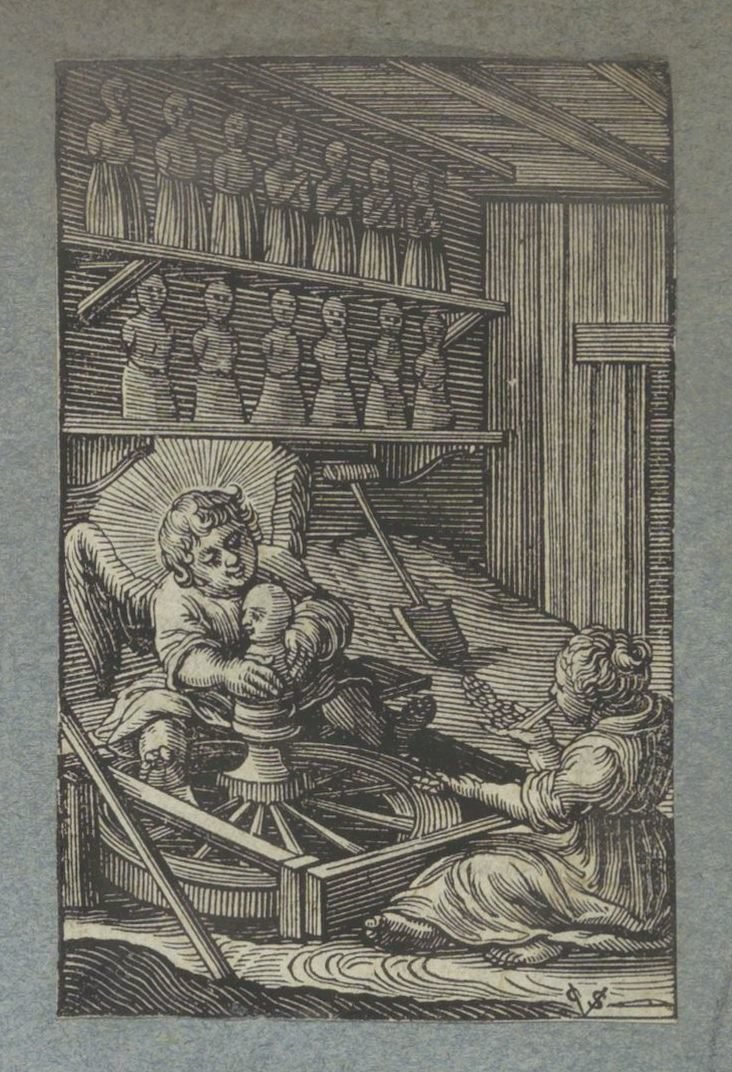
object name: book illustration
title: Pia Desideria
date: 1628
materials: paper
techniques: woodcut, pasting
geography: antwerp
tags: handicrafts ~ clay, sand, chalk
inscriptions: collector's mark: Lugt 2165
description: Een kind kijkt toe hoe een engel een beeldje maakt van klei op een draaitafel. Dit is een verwijzing naar hoe God de mens schiep uit klei. Achter de engel twee planken met meer beeldjes. Het kind blaast droge klei deeltjes als een wolkje stof van haar hand als teken van de vergankelijkheid van de mens. De prent maakt deel uit van een album.